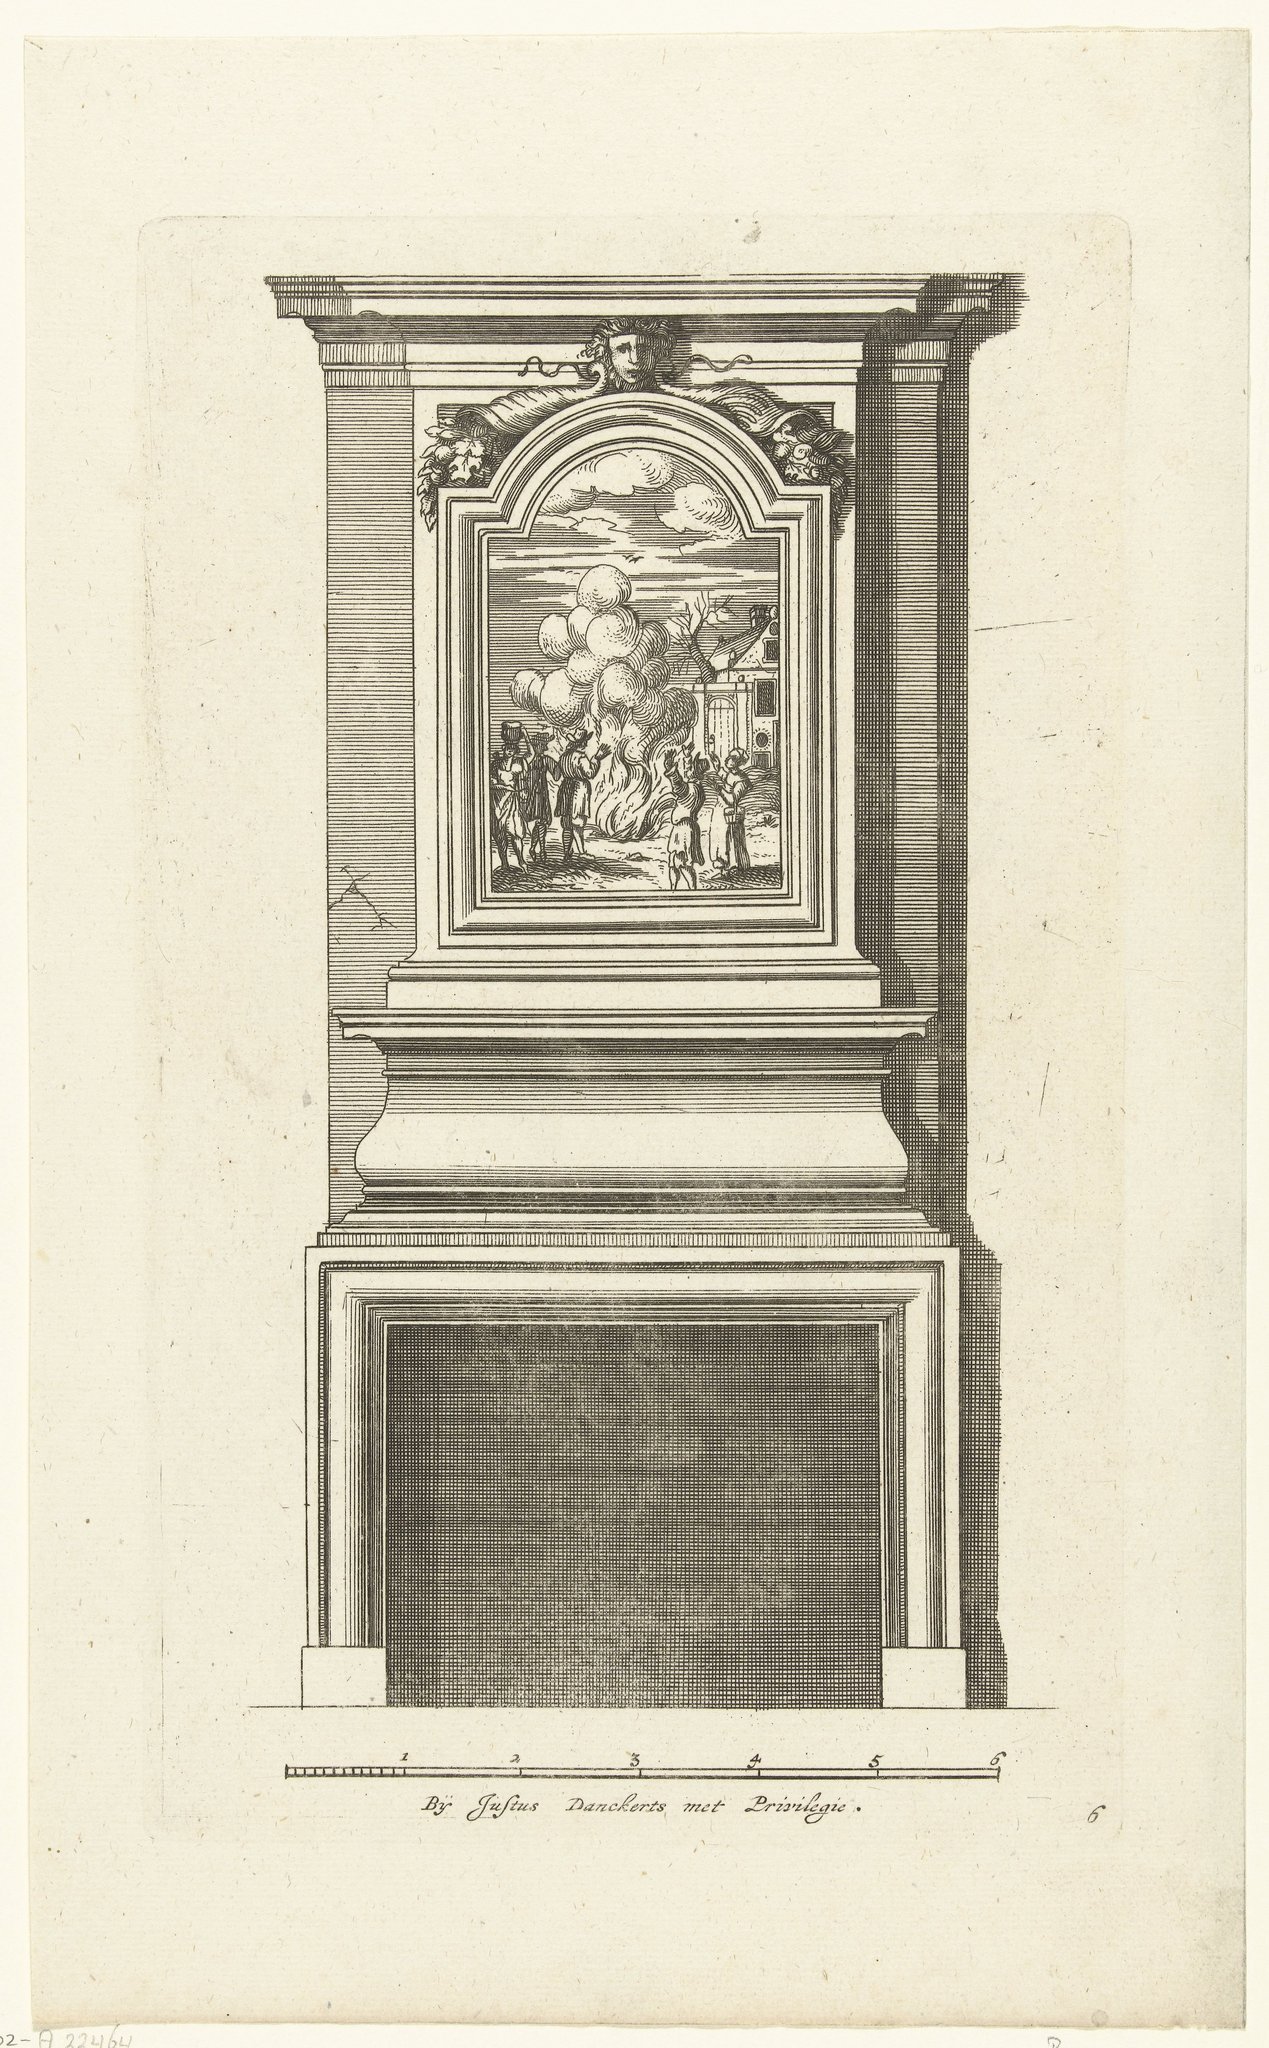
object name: print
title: Verschyde Schoorsteen Mantels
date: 1675-1686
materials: paper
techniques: etching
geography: netherlands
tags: chimney-piece, mantelpiece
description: Boven de schoorsteenstoel hangt een rechthoekig schilderij met mannen die zichzelf warmen aan een vuur.